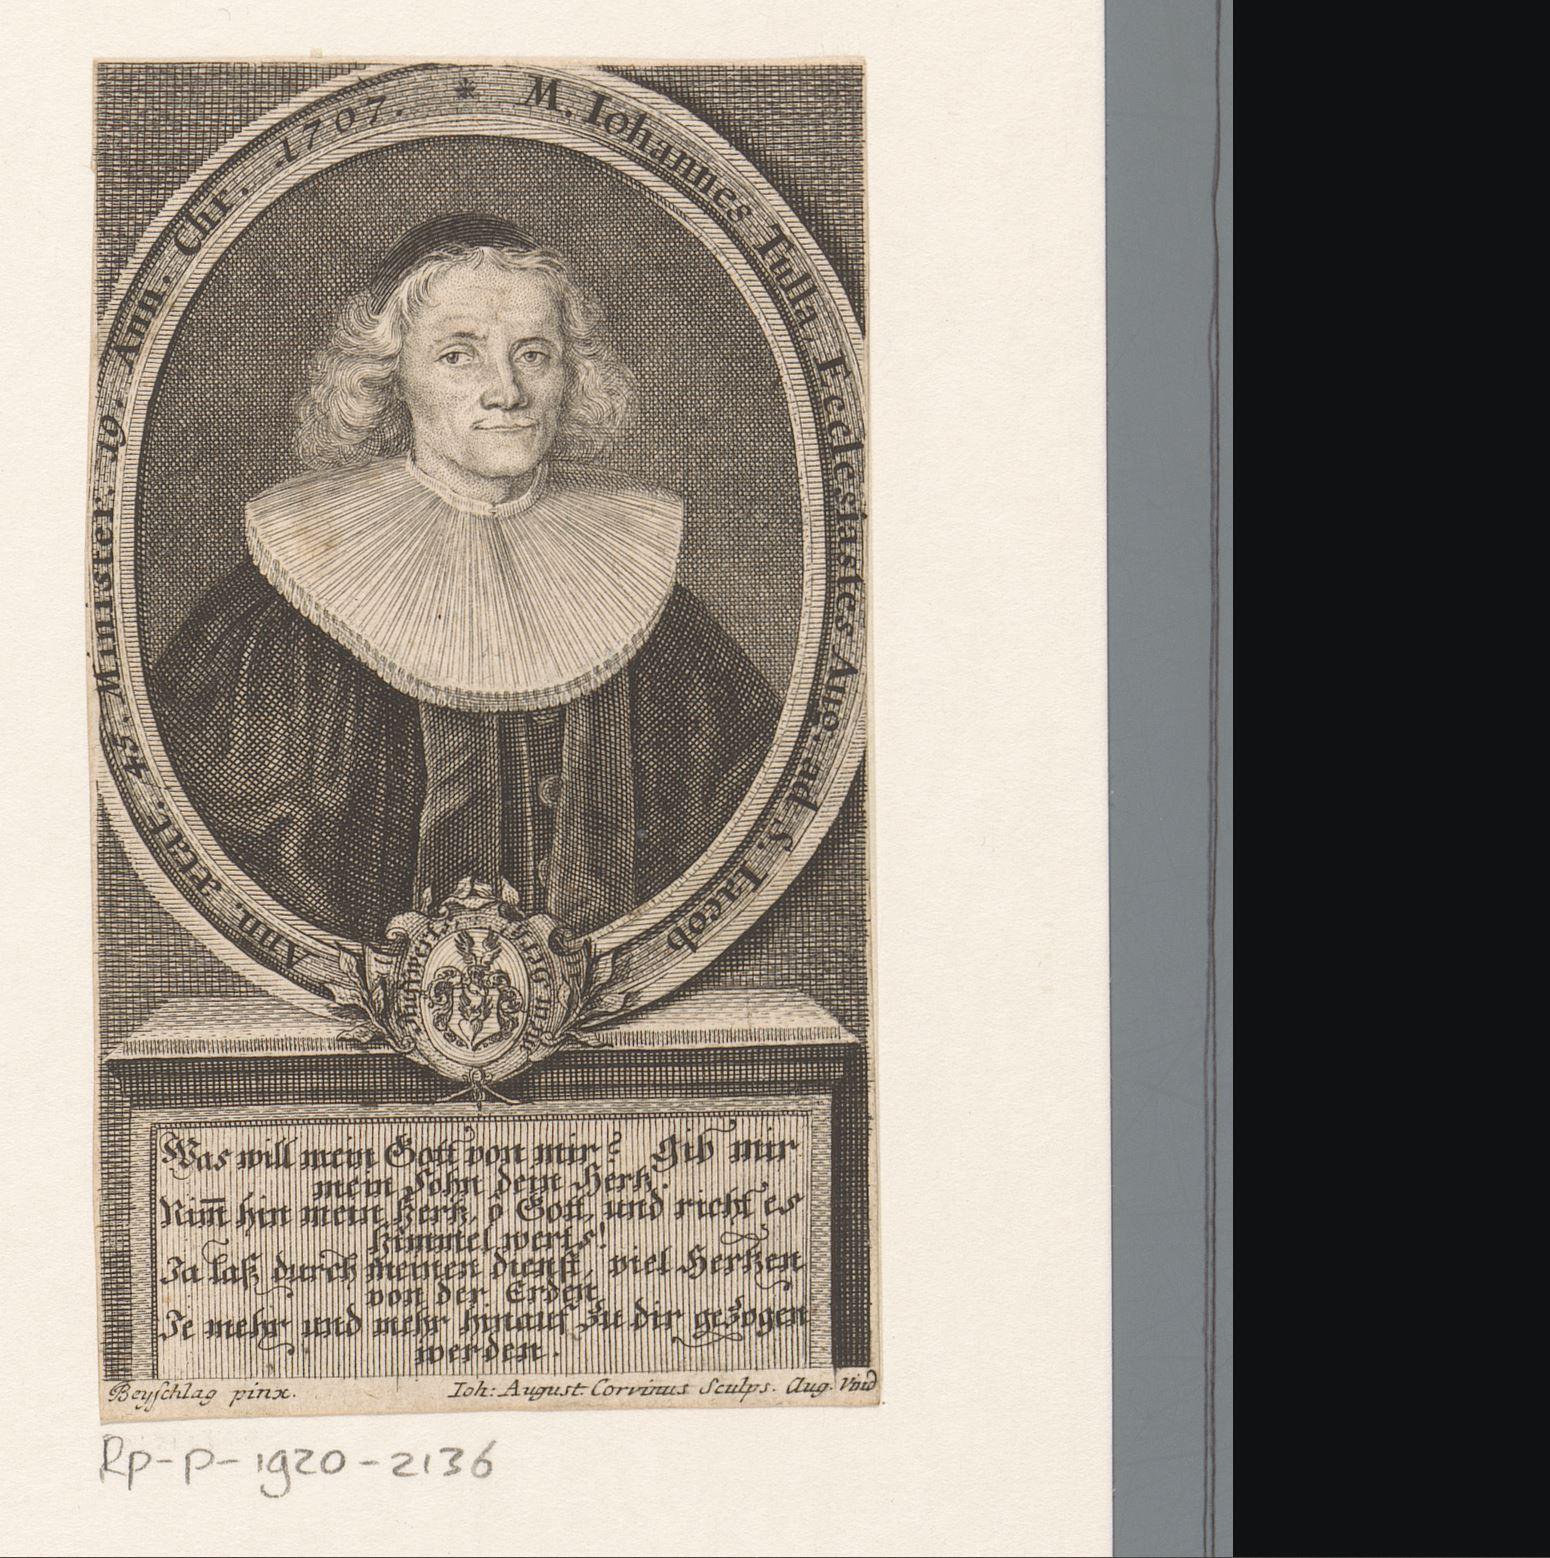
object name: print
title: Portret van Johannes Tulla op 45-jarige leeftijd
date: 1693-1738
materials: paper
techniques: engraving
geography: augsburg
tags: augsburg, historical persons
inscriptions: collector's mark: Lugt 2228